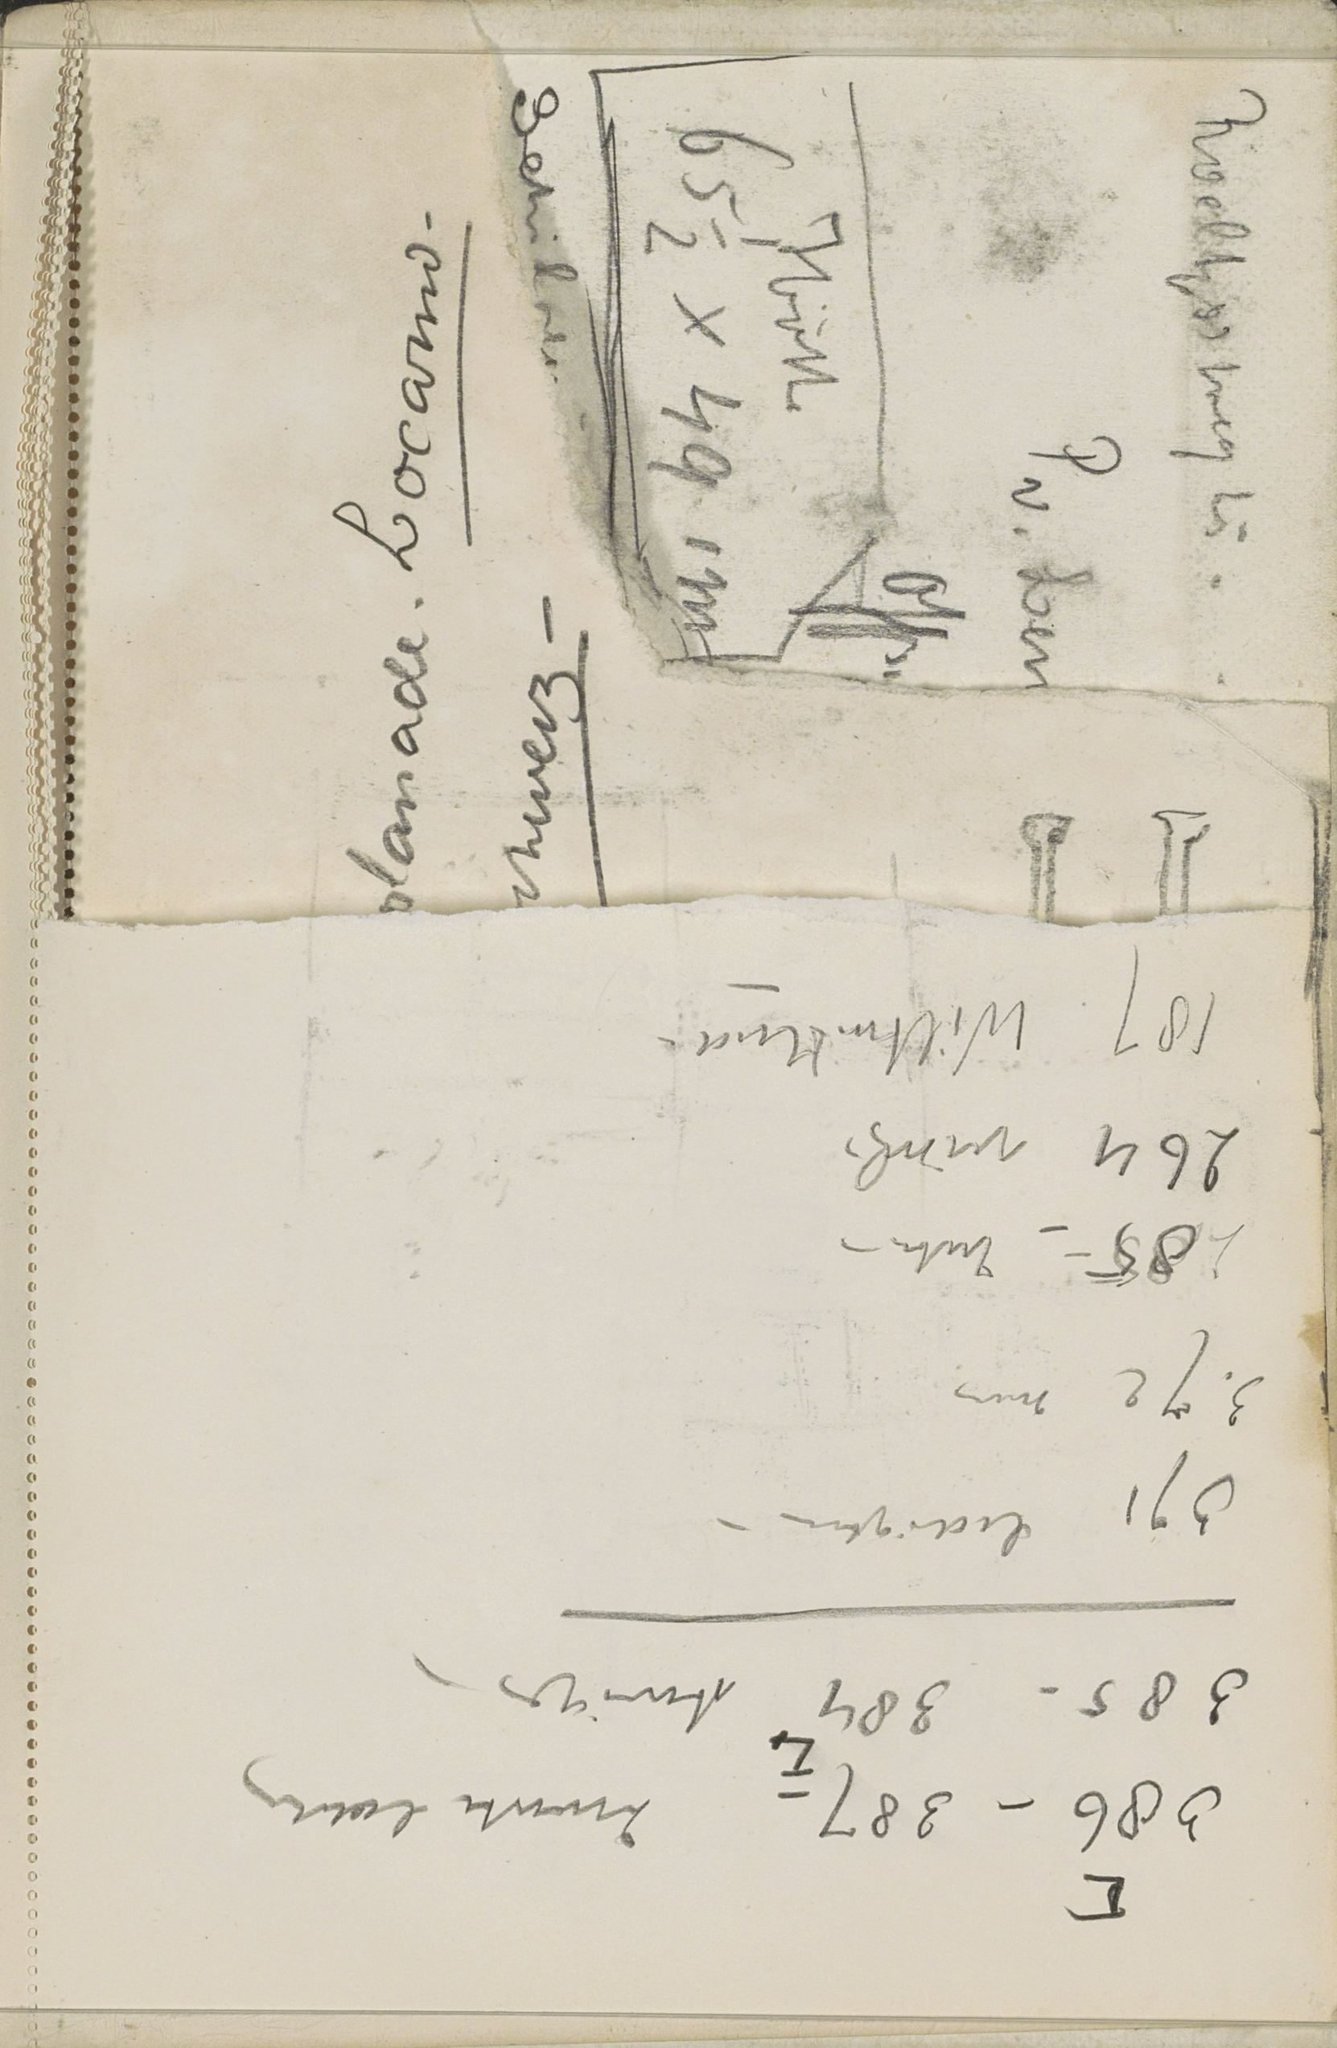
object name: sketchbook leaf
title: Notities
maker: cornelis vreedenburgh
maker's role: draughtsman, print maker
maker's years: 1880-1946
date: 1890-1946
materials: paper, pencil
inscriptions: annotation: ‘386-387 zwarte [...]/ 285 -384 steviger [...]’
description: De pagina is voor de helft uit het schetsboek gescheurd.